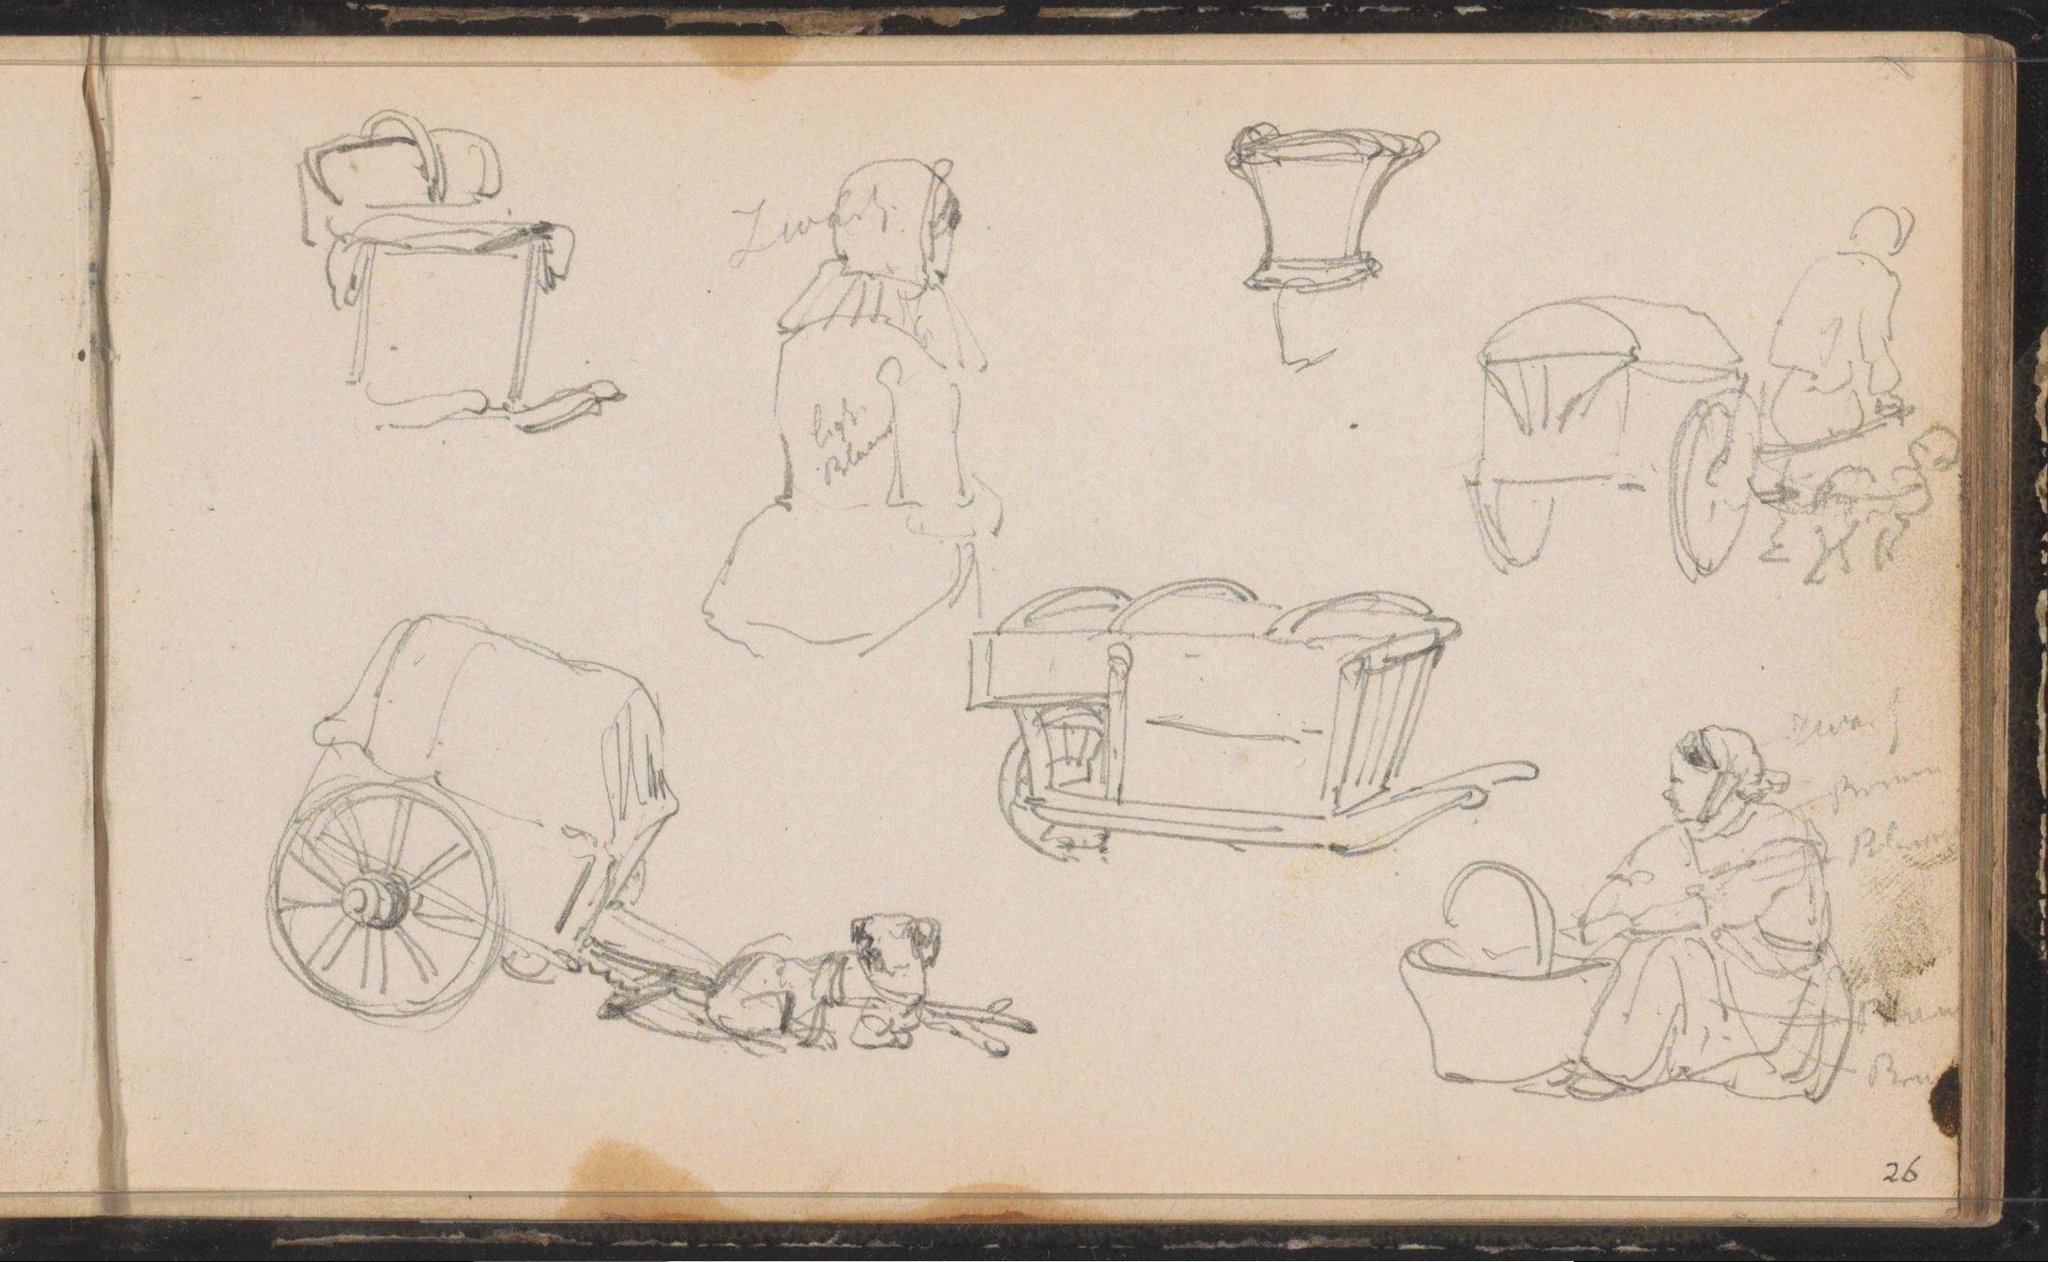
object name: sketchbook leaf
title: Figuren en karren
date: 1863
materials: paper, pencil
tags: hand-cart, adult man, dog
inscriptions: kleurnotitie, handgeschreven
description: Vrouwen in verschillende houdingen en karren. Linksonder een hond voor een kar. Blad 26 uit een schetsboek met 55 bladen vervaardigd op de Veluwe en in Noord-Duitsland.